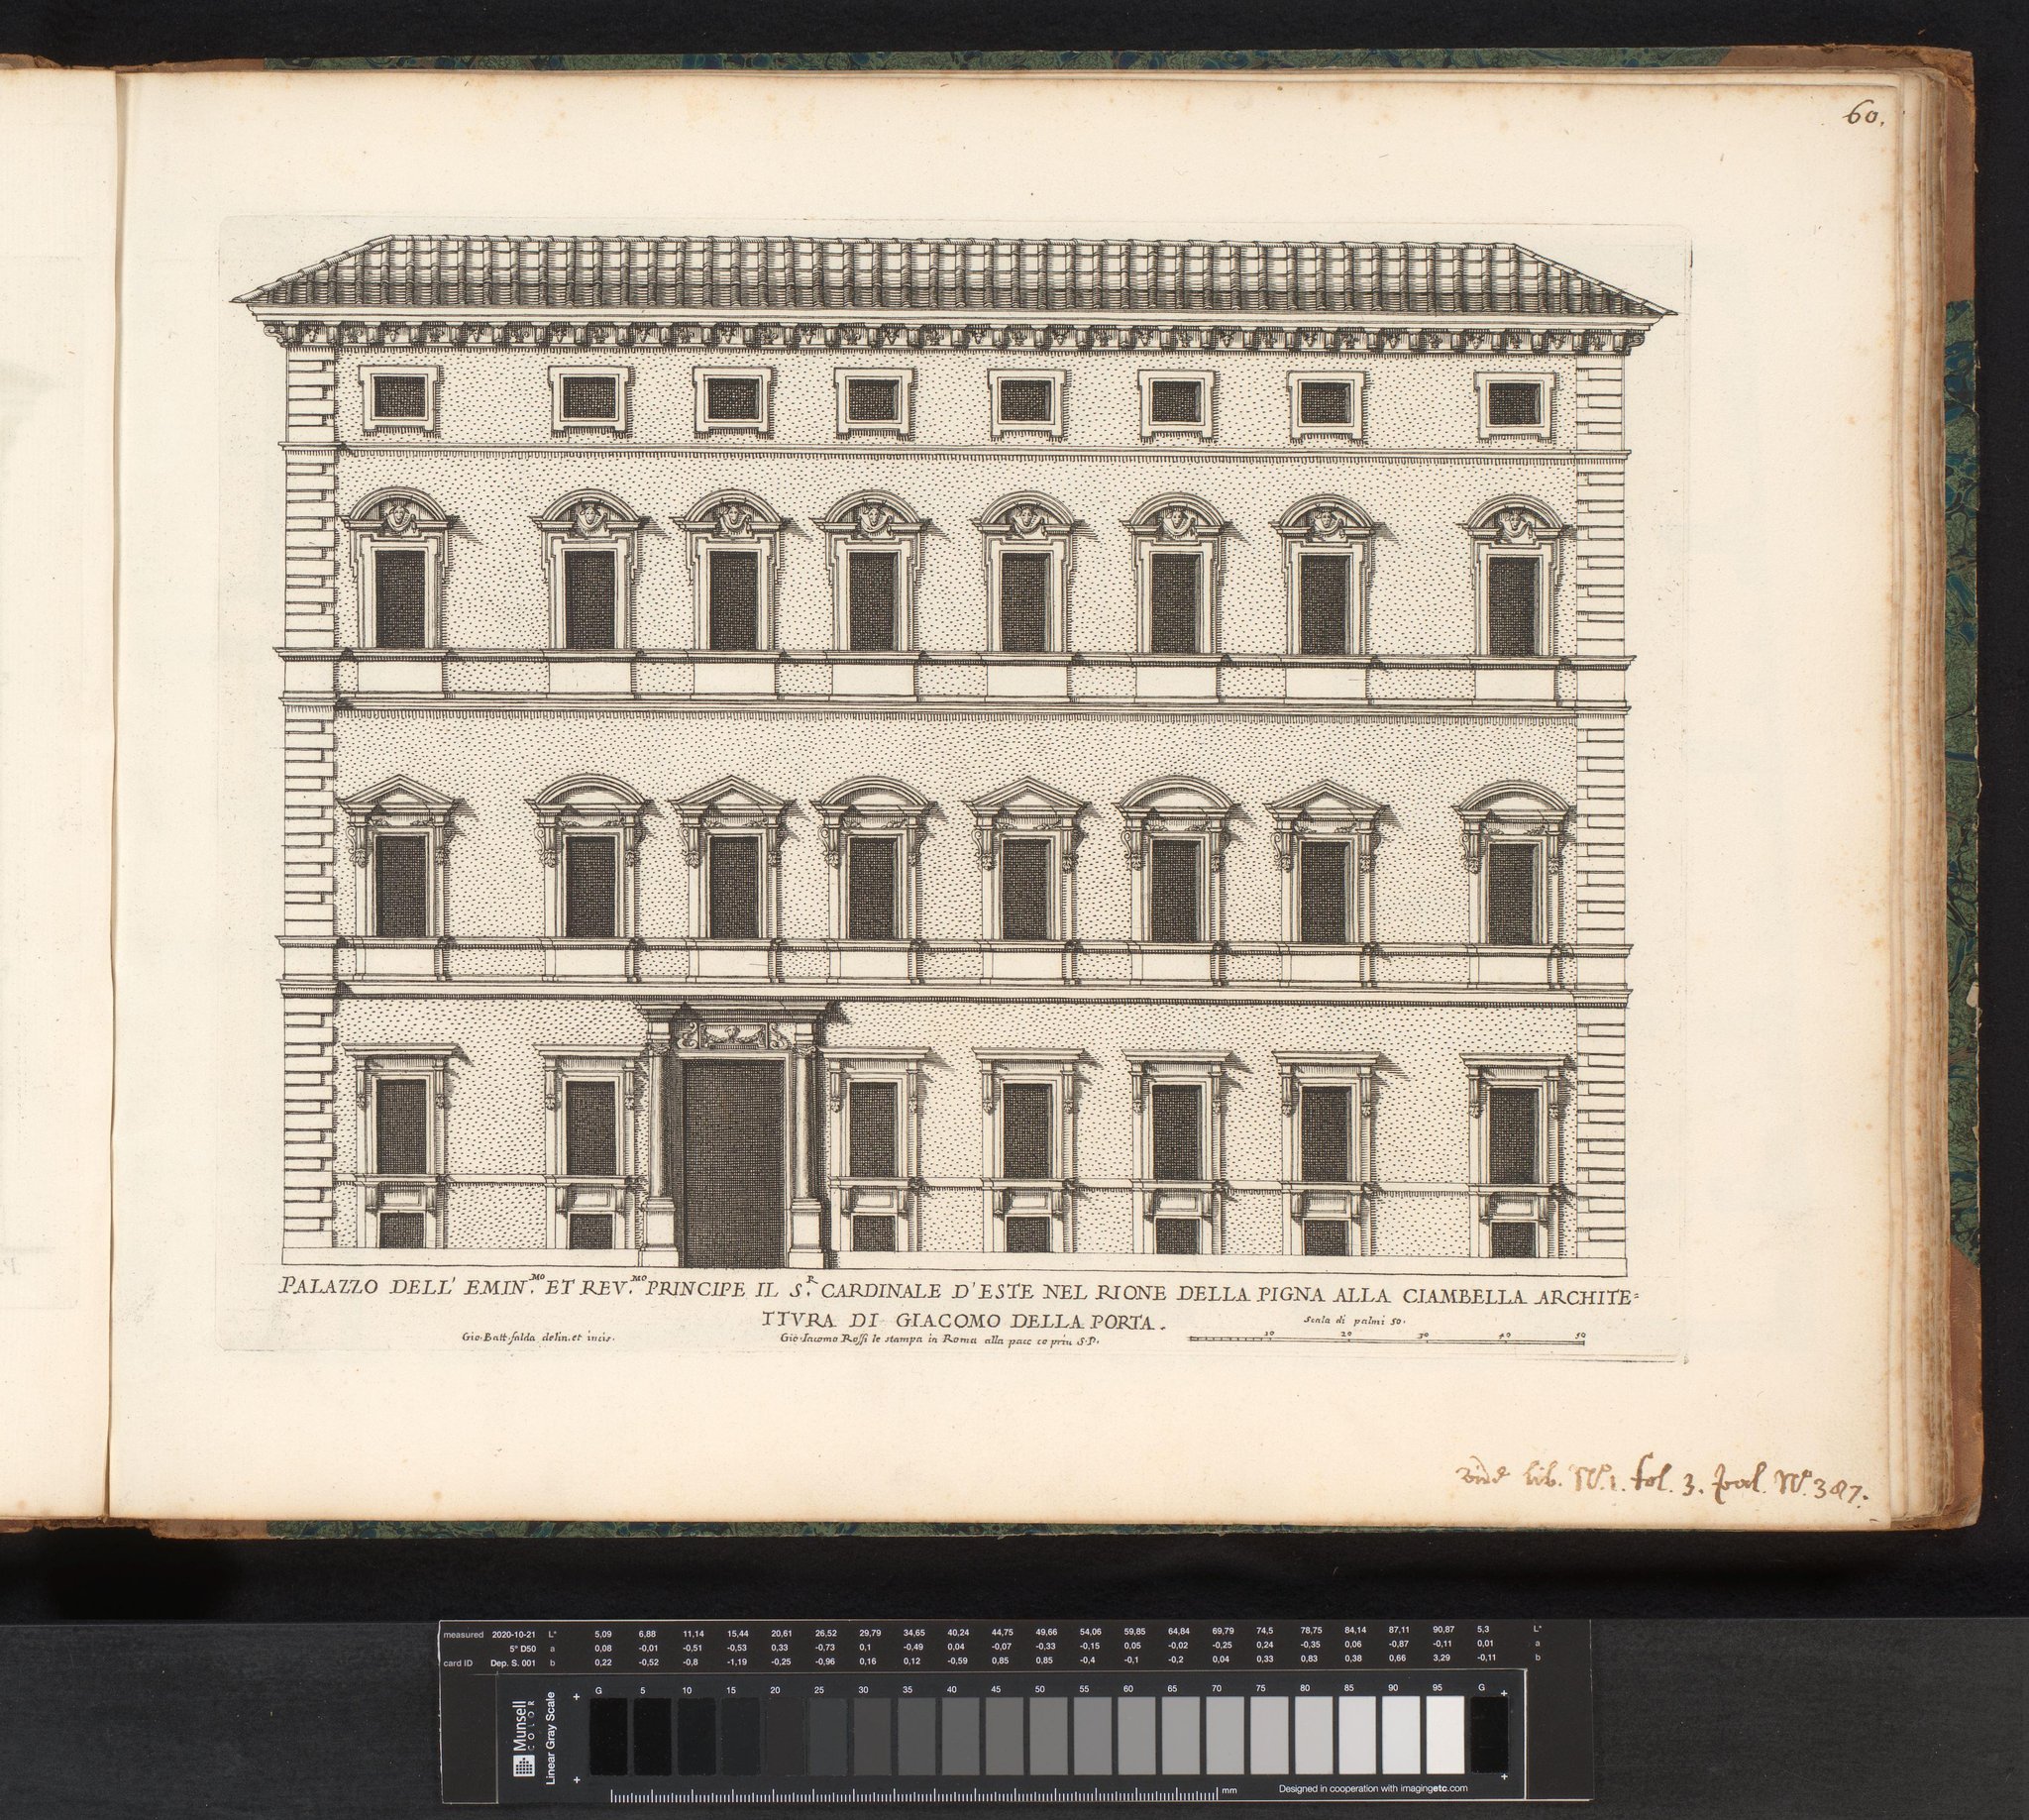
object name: print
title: Palazzi di Roma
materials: paper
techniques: etching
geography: rome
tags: palace, façade (of house or building), rome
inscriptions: number: ‘60’, inscription: ‘Ende lib. No. 1. fol. 3. [...] No. 387.’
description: Deze prent maakt deel uit van de reeks getiteld: Palazzi di Roma. Deze reeks bestaat uit twee boeken. Boek één getiteld: Palazzi di Roma dei più celebri architetti..., bestaat uit 44 prenten die worden toegeschreven aan Giovanni Battista Falda (naam staat enkel op prent 27) en uitgegeven door Giovanni Giacomo de'Rossi. Deze 44 prenten zijn bekend in twee staten (met en zonder nummer). Boek twee getiteld: Nuovi disegni dell'architetture... libro secondo, bevat 66 prenten door Giovanni Battista Falda en Simone Felice. Deze 66 prenten zijn bekend in twee staten (met en zonder nummer).